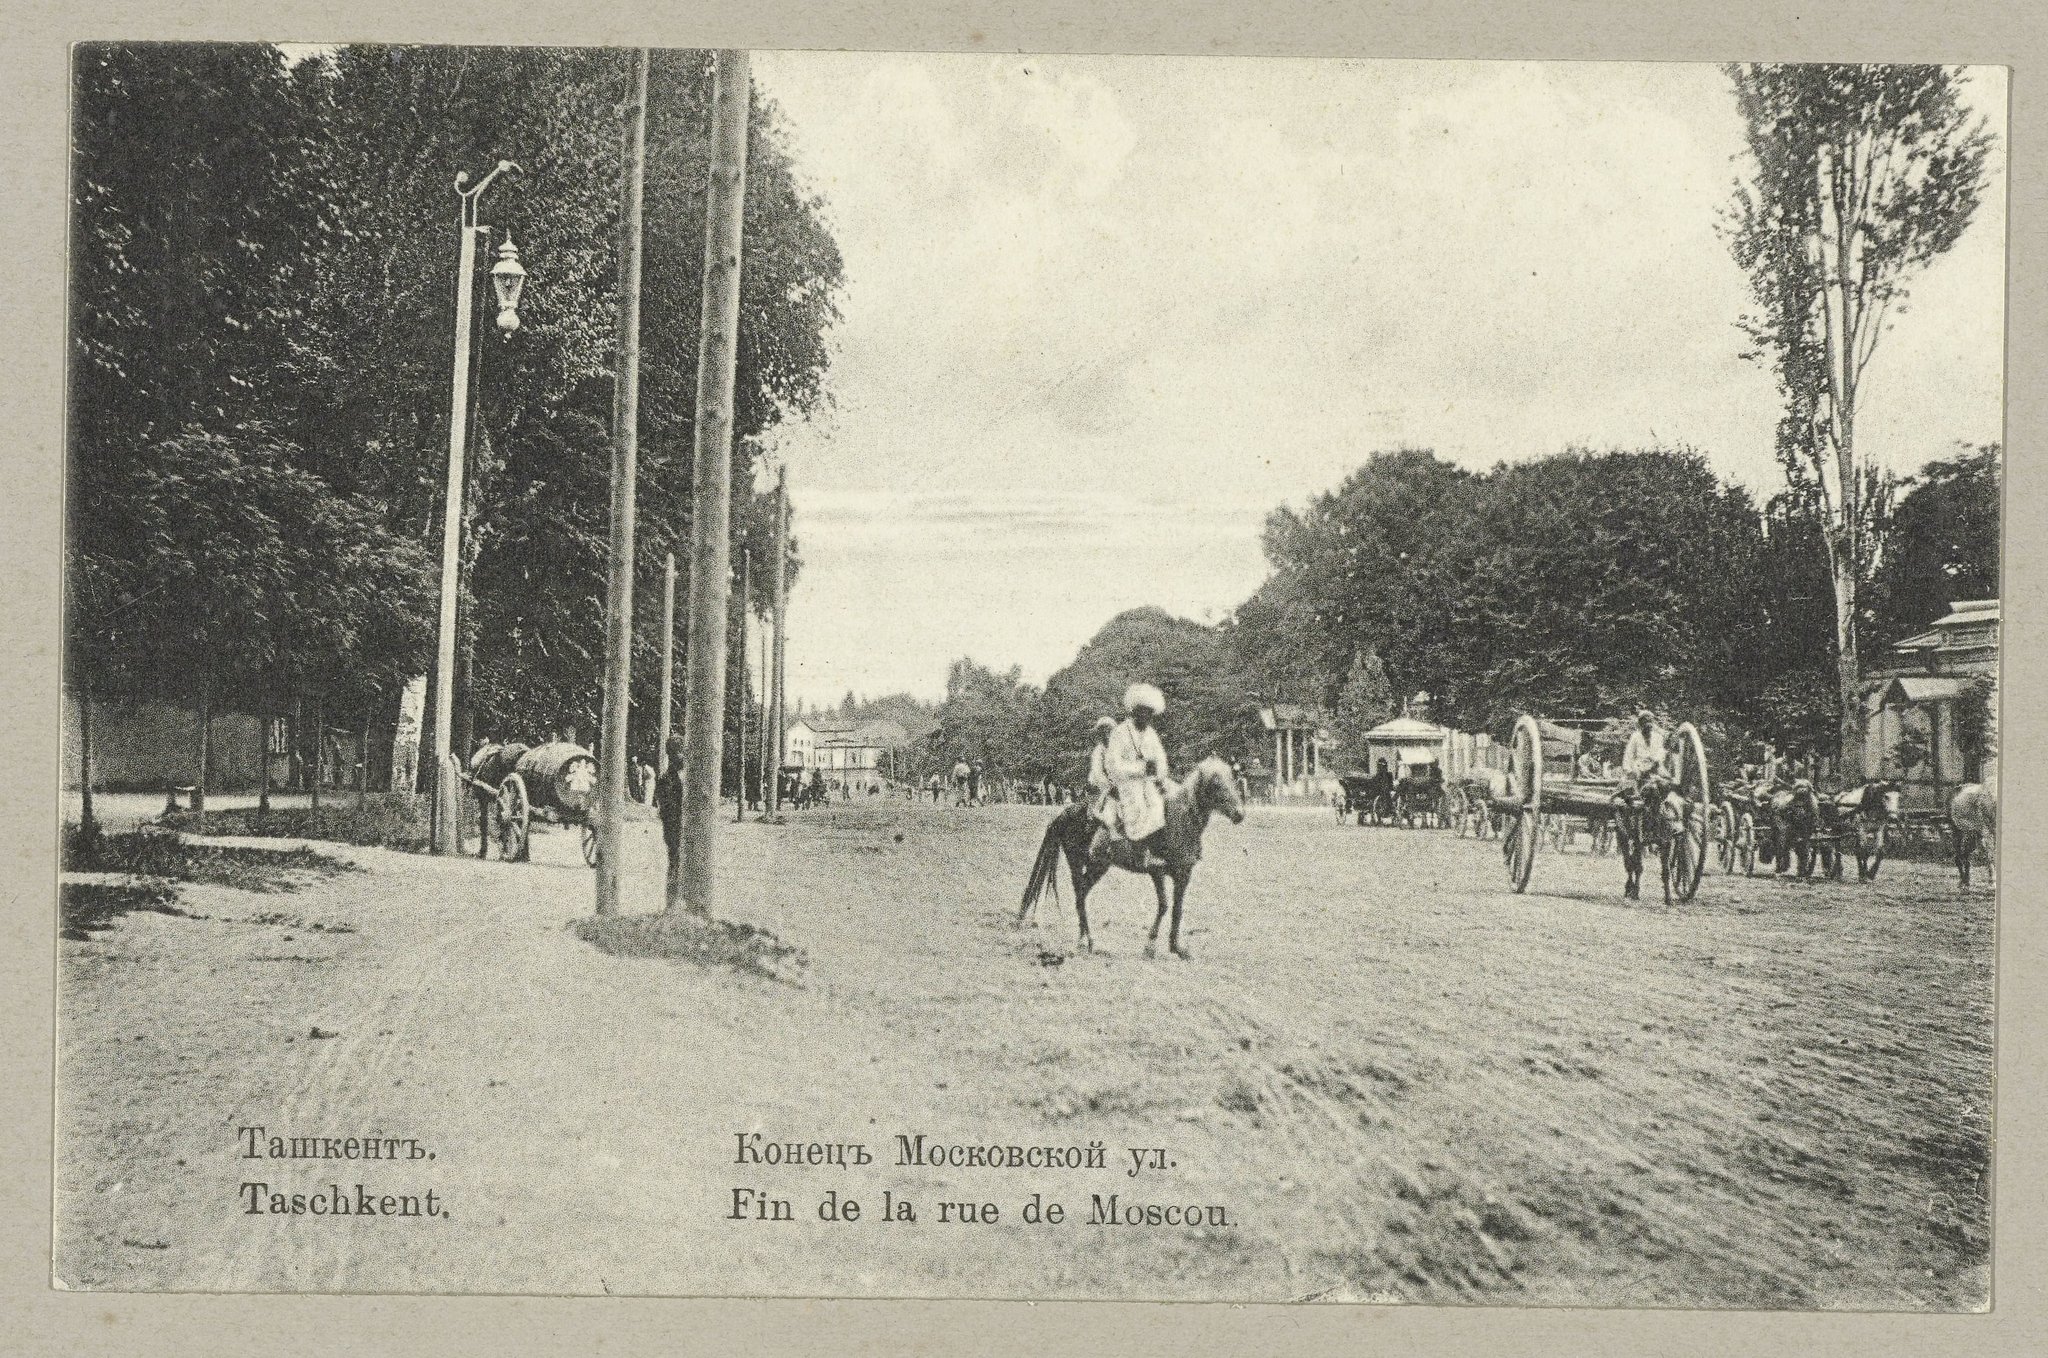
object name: photomechanical print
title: Einde van de weg van Moskou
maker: Anonymous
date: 1895-1915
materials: cardboard, paper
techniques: photograph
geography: tashkent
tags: tashkent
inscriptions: number: ‘1.’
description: Boven de titels in het Frans staan de titels in het Oezbeeks.